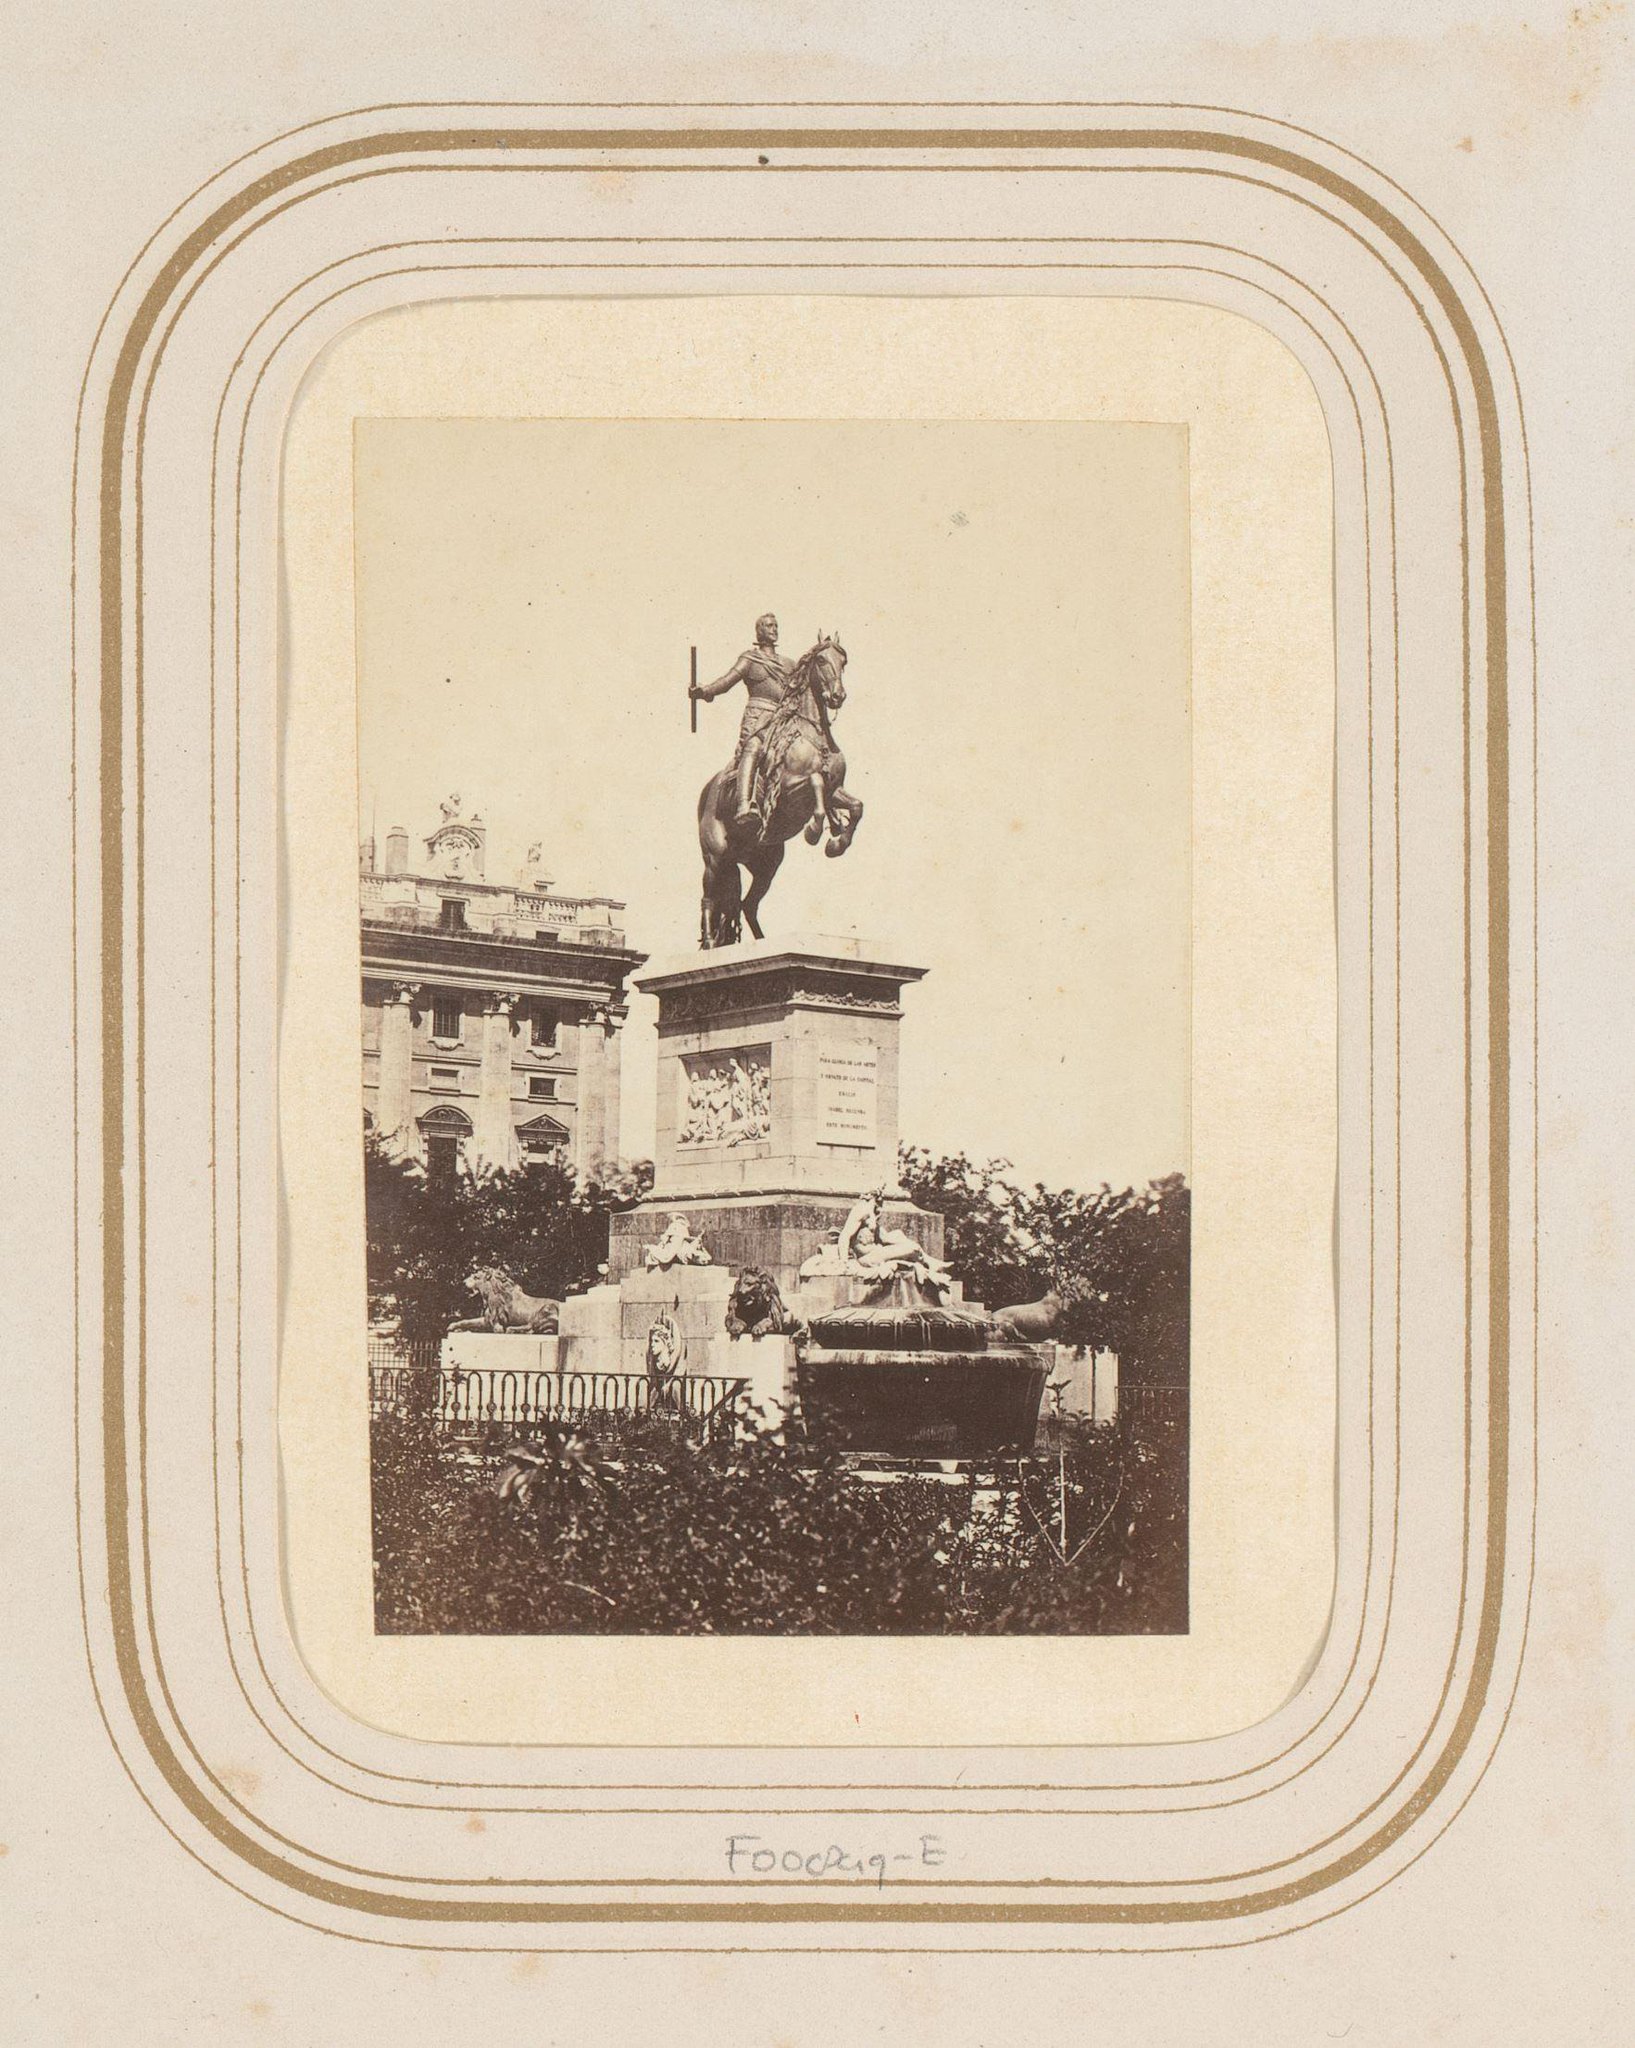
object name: album leaf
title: Ruiterstandbeeld van Filips IV op Plaza de Oriente in Madrid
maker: juan laurent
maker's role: publisher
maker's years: 1816-1896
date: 1857-1880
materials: cardboard, photographic support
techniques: albumen print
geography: madrid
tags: filips iv (koning van spanje), equestrian statue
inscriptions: annotation: ‘Philippe IV’, inscription: ‘MONUMENTS ET VUES D'ESPAGNE/ J. LAURENT, Fotog. / Dépot Central./ 39, Carrera S. Geronimo, MADRID/ 27, Rue Richelieu, PARIS’